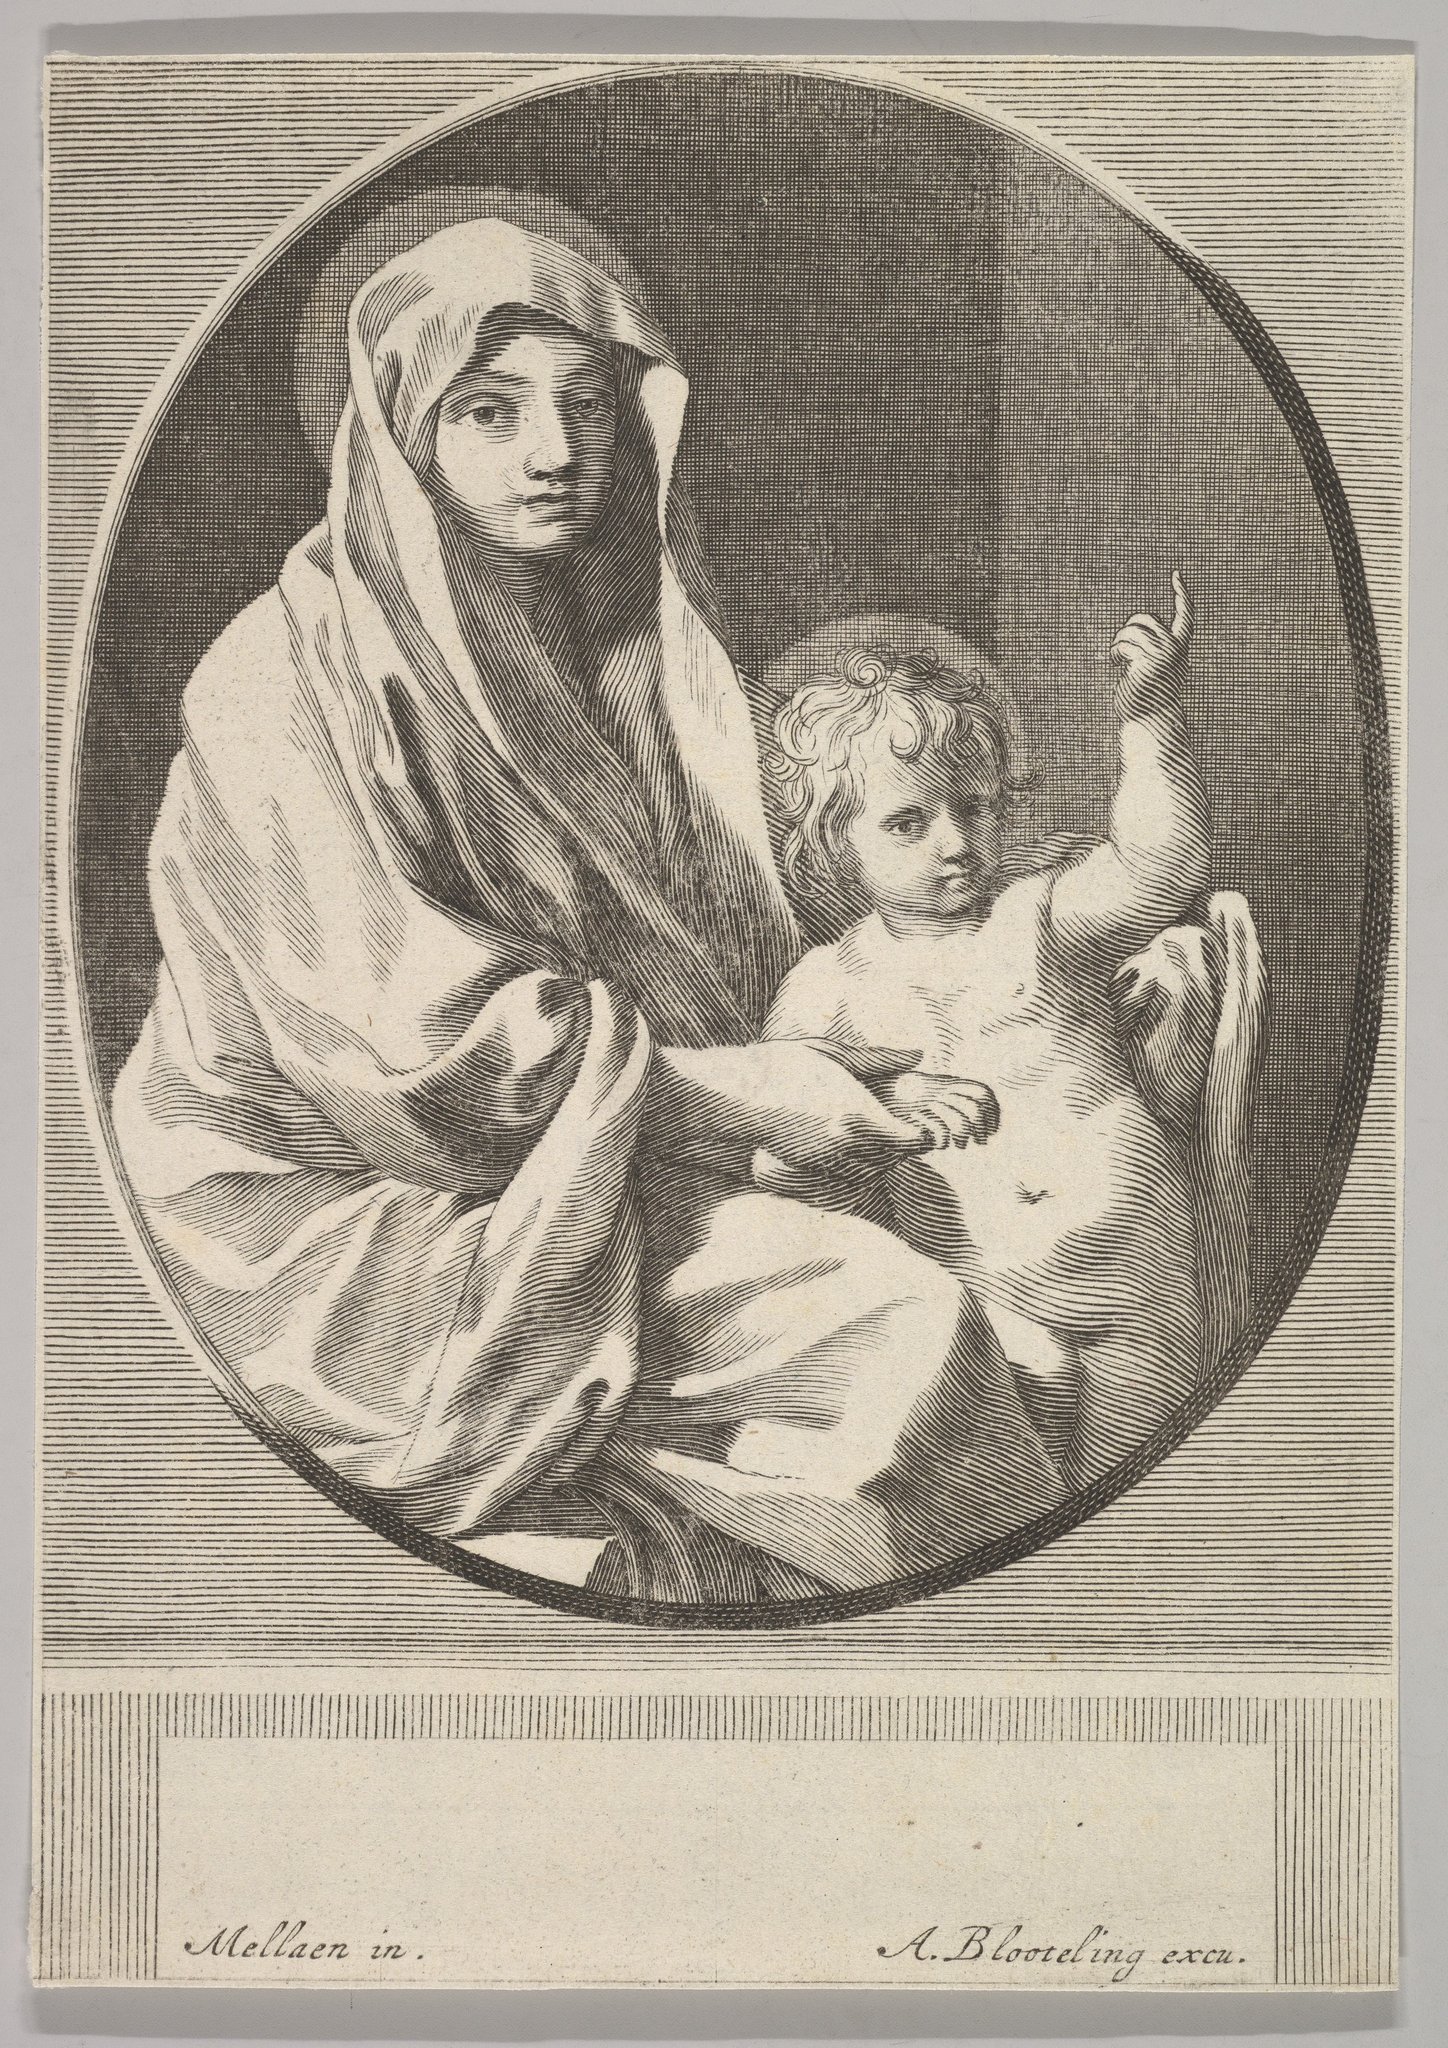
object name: print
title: Virgin and Child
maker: abraham blooteling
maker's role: artist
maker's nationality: dutch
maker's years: 1640-1690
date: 1640-1690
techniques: engraving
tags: madonna and child